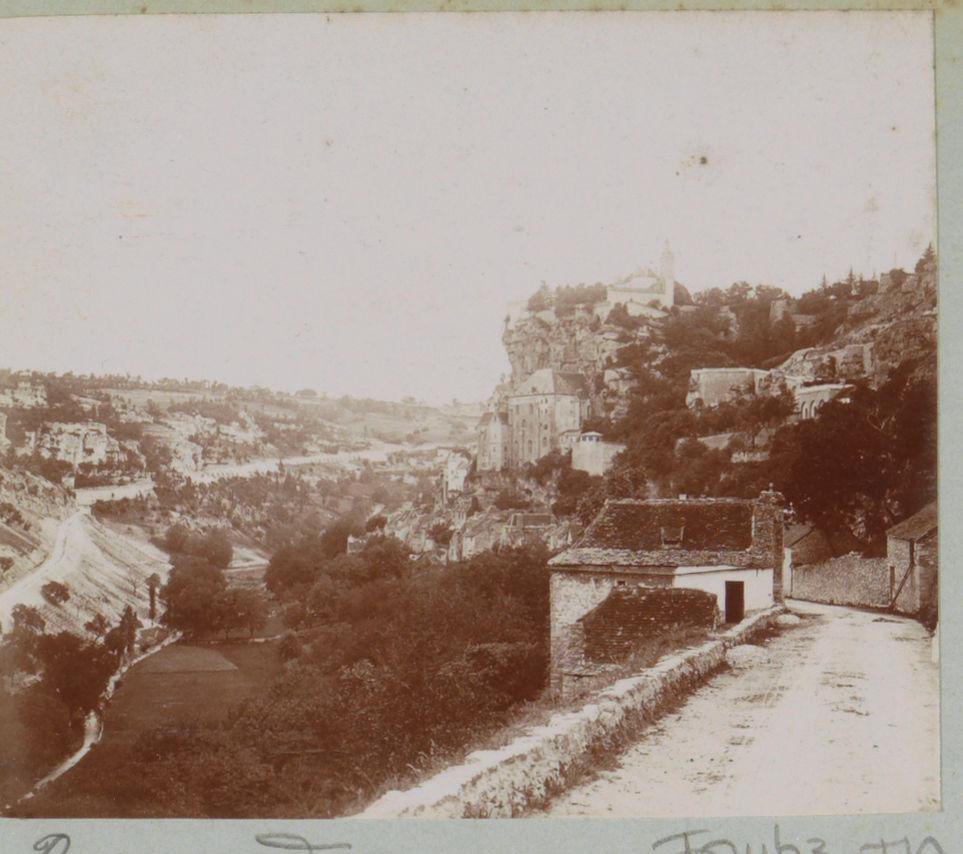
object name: photograph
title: Gezicht op Rocamadour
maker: delizy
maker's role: manufacturer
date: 1903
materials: paper, photographic support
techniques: gelatin silver print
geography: rocamadour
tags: prospect of village, silhouette of village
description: Onderdeel van Fotoalbum van een Franse amateurfotograaf met opnames van uitstapjes in Frankrijk, Spanje, België, Luxemburg en Nederland, de eerste automobielen en autoraces.